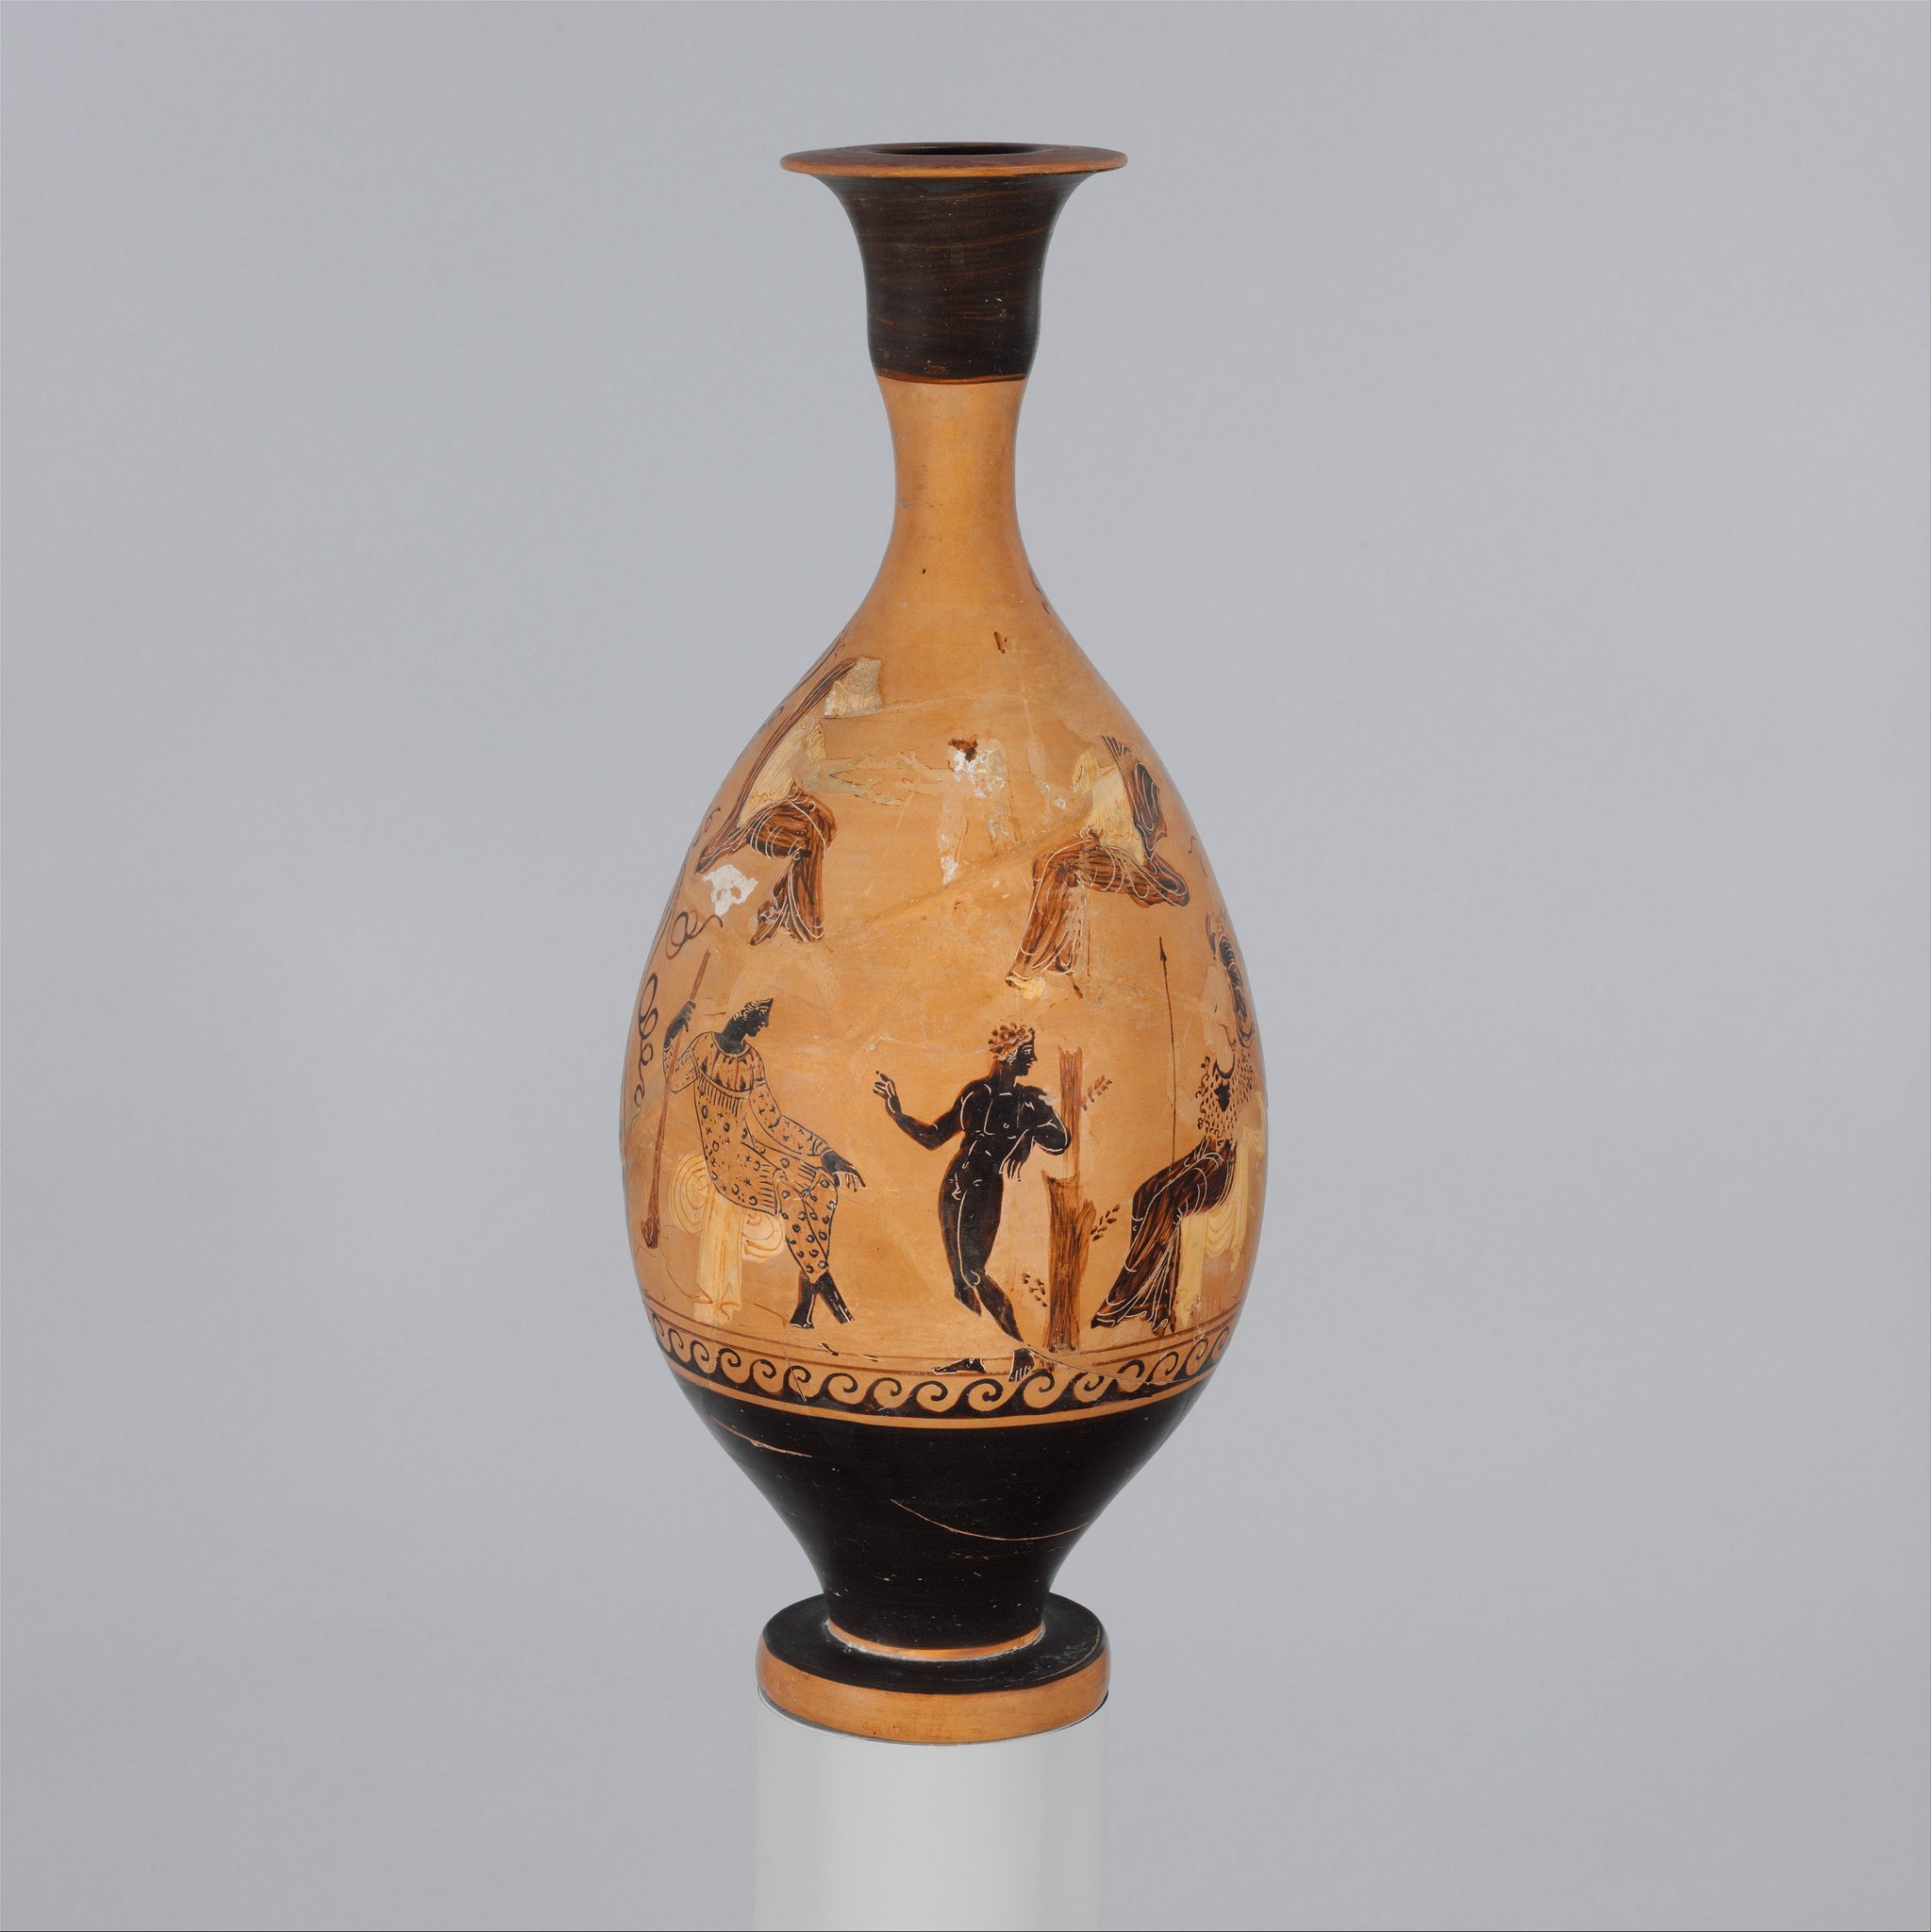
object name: lekythos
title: Terracotta lekythos (oil flask)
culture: greek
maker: pagenstecher class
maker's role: artist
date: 367-335 BCE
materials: terracotta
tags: aphrodite,athena,eros,hermes